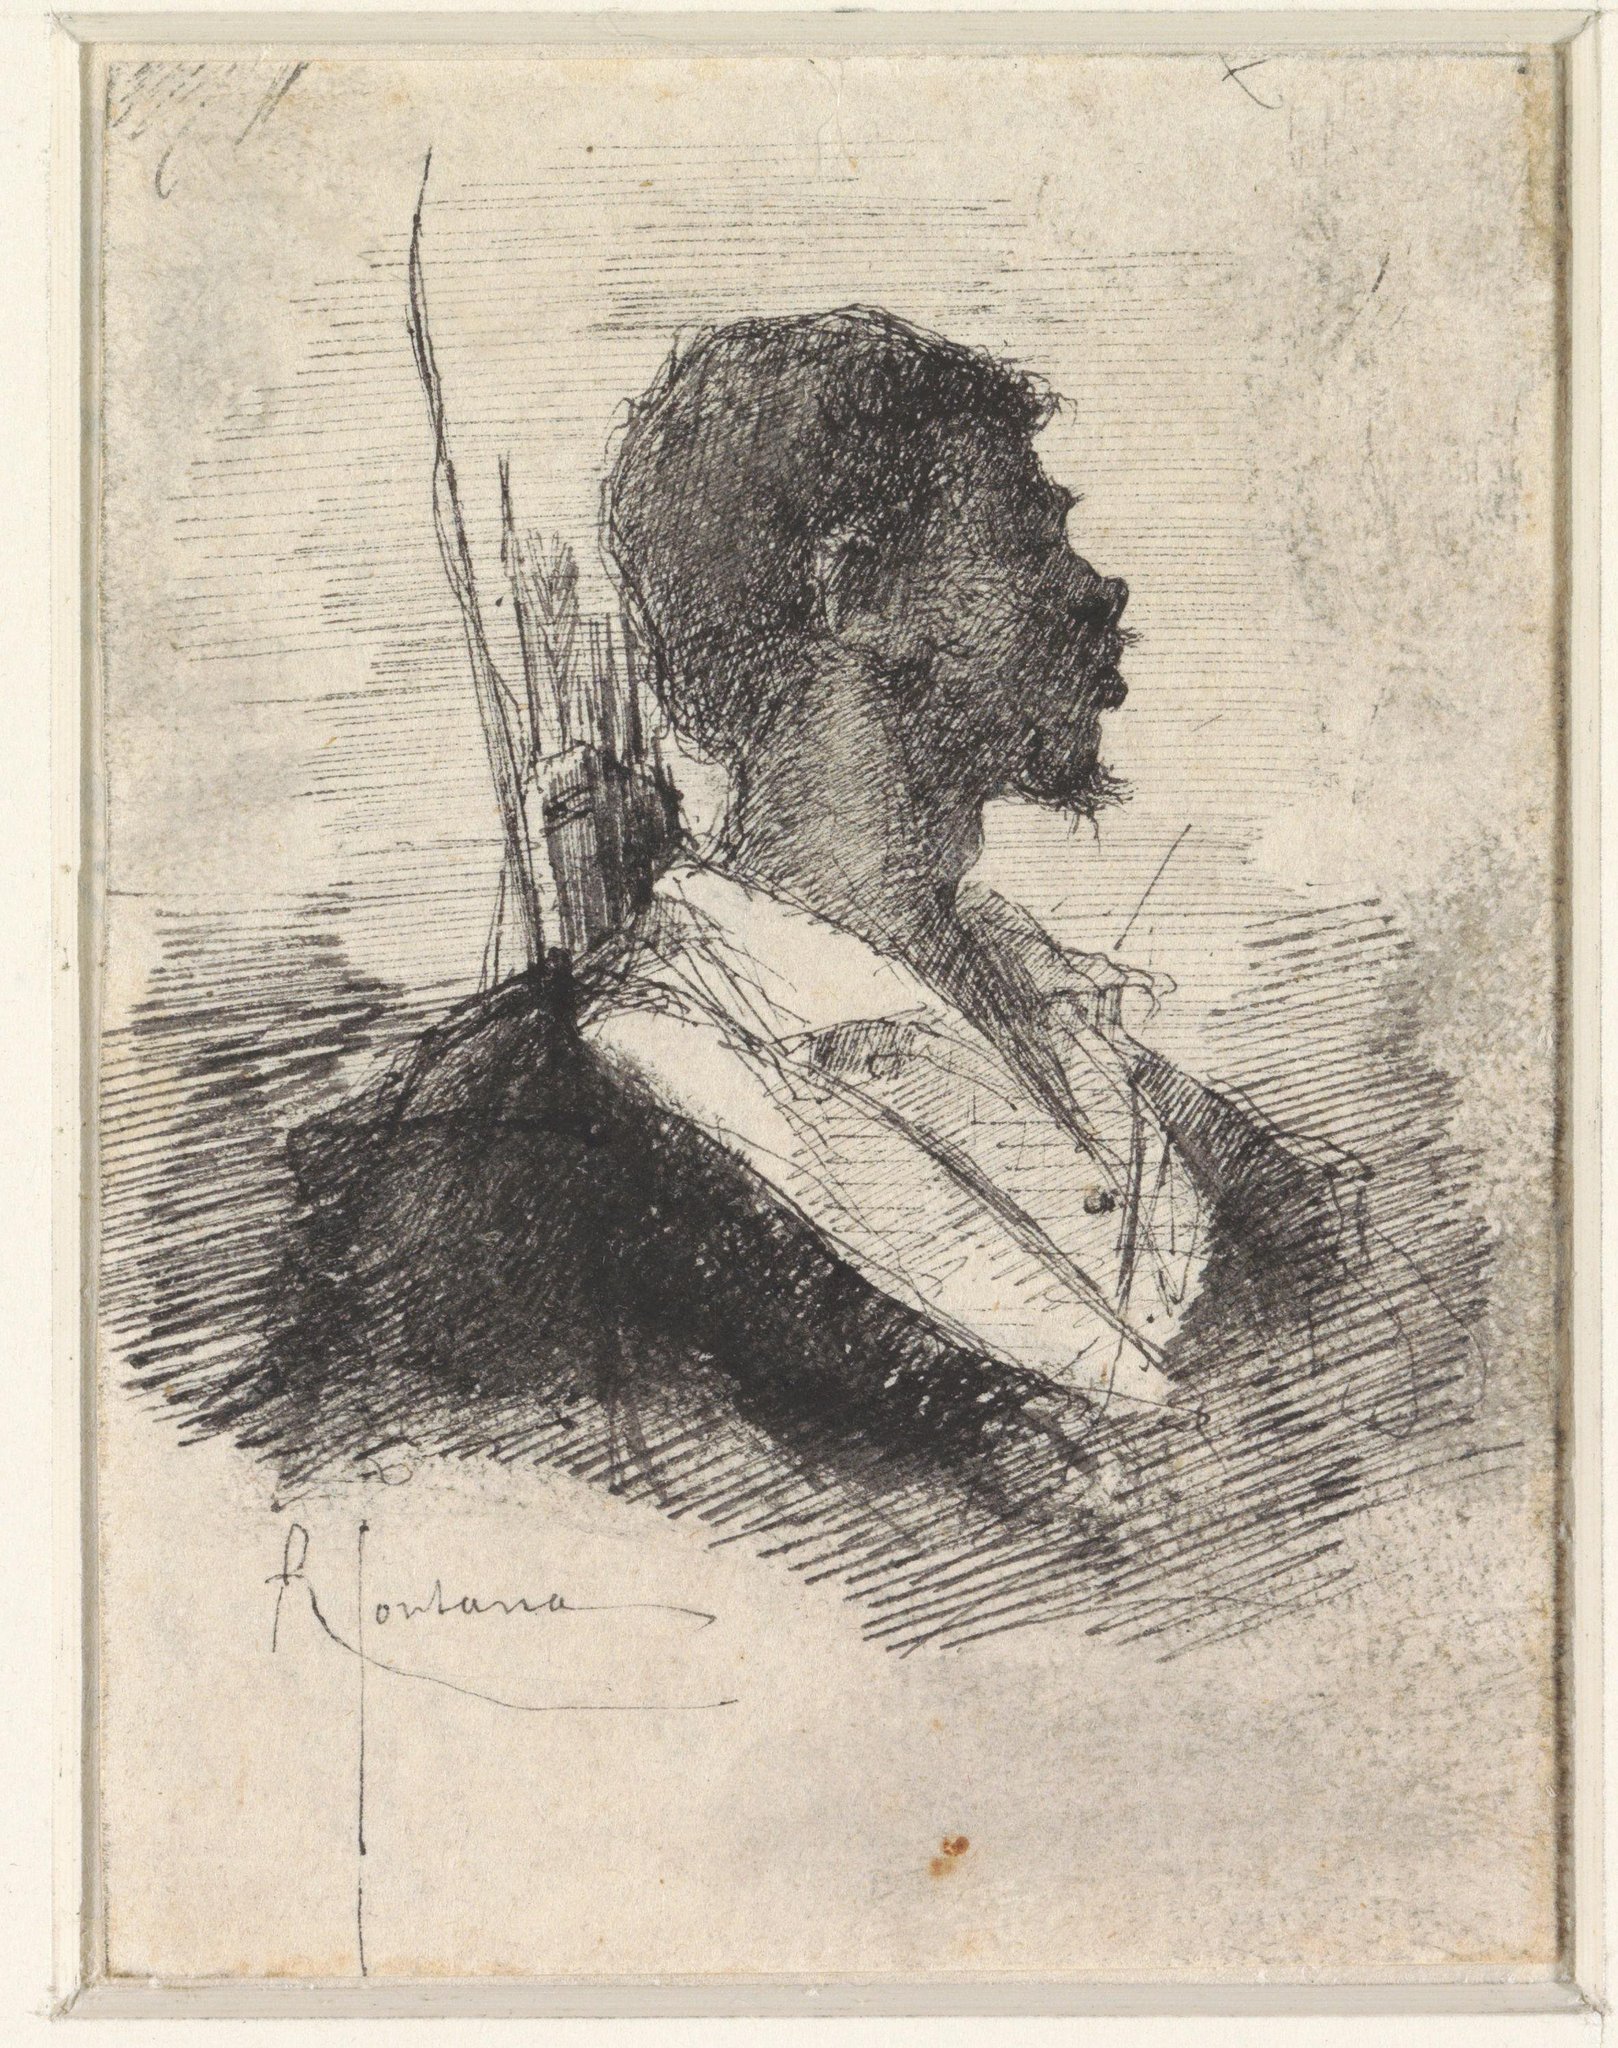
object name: drawing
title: Buste van een zwarte man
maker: roberto fontana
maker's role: draughtsman, print maker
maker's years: 1844-1907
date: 1854-1886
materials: ink, paper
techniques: pen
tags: africans, male sex; man